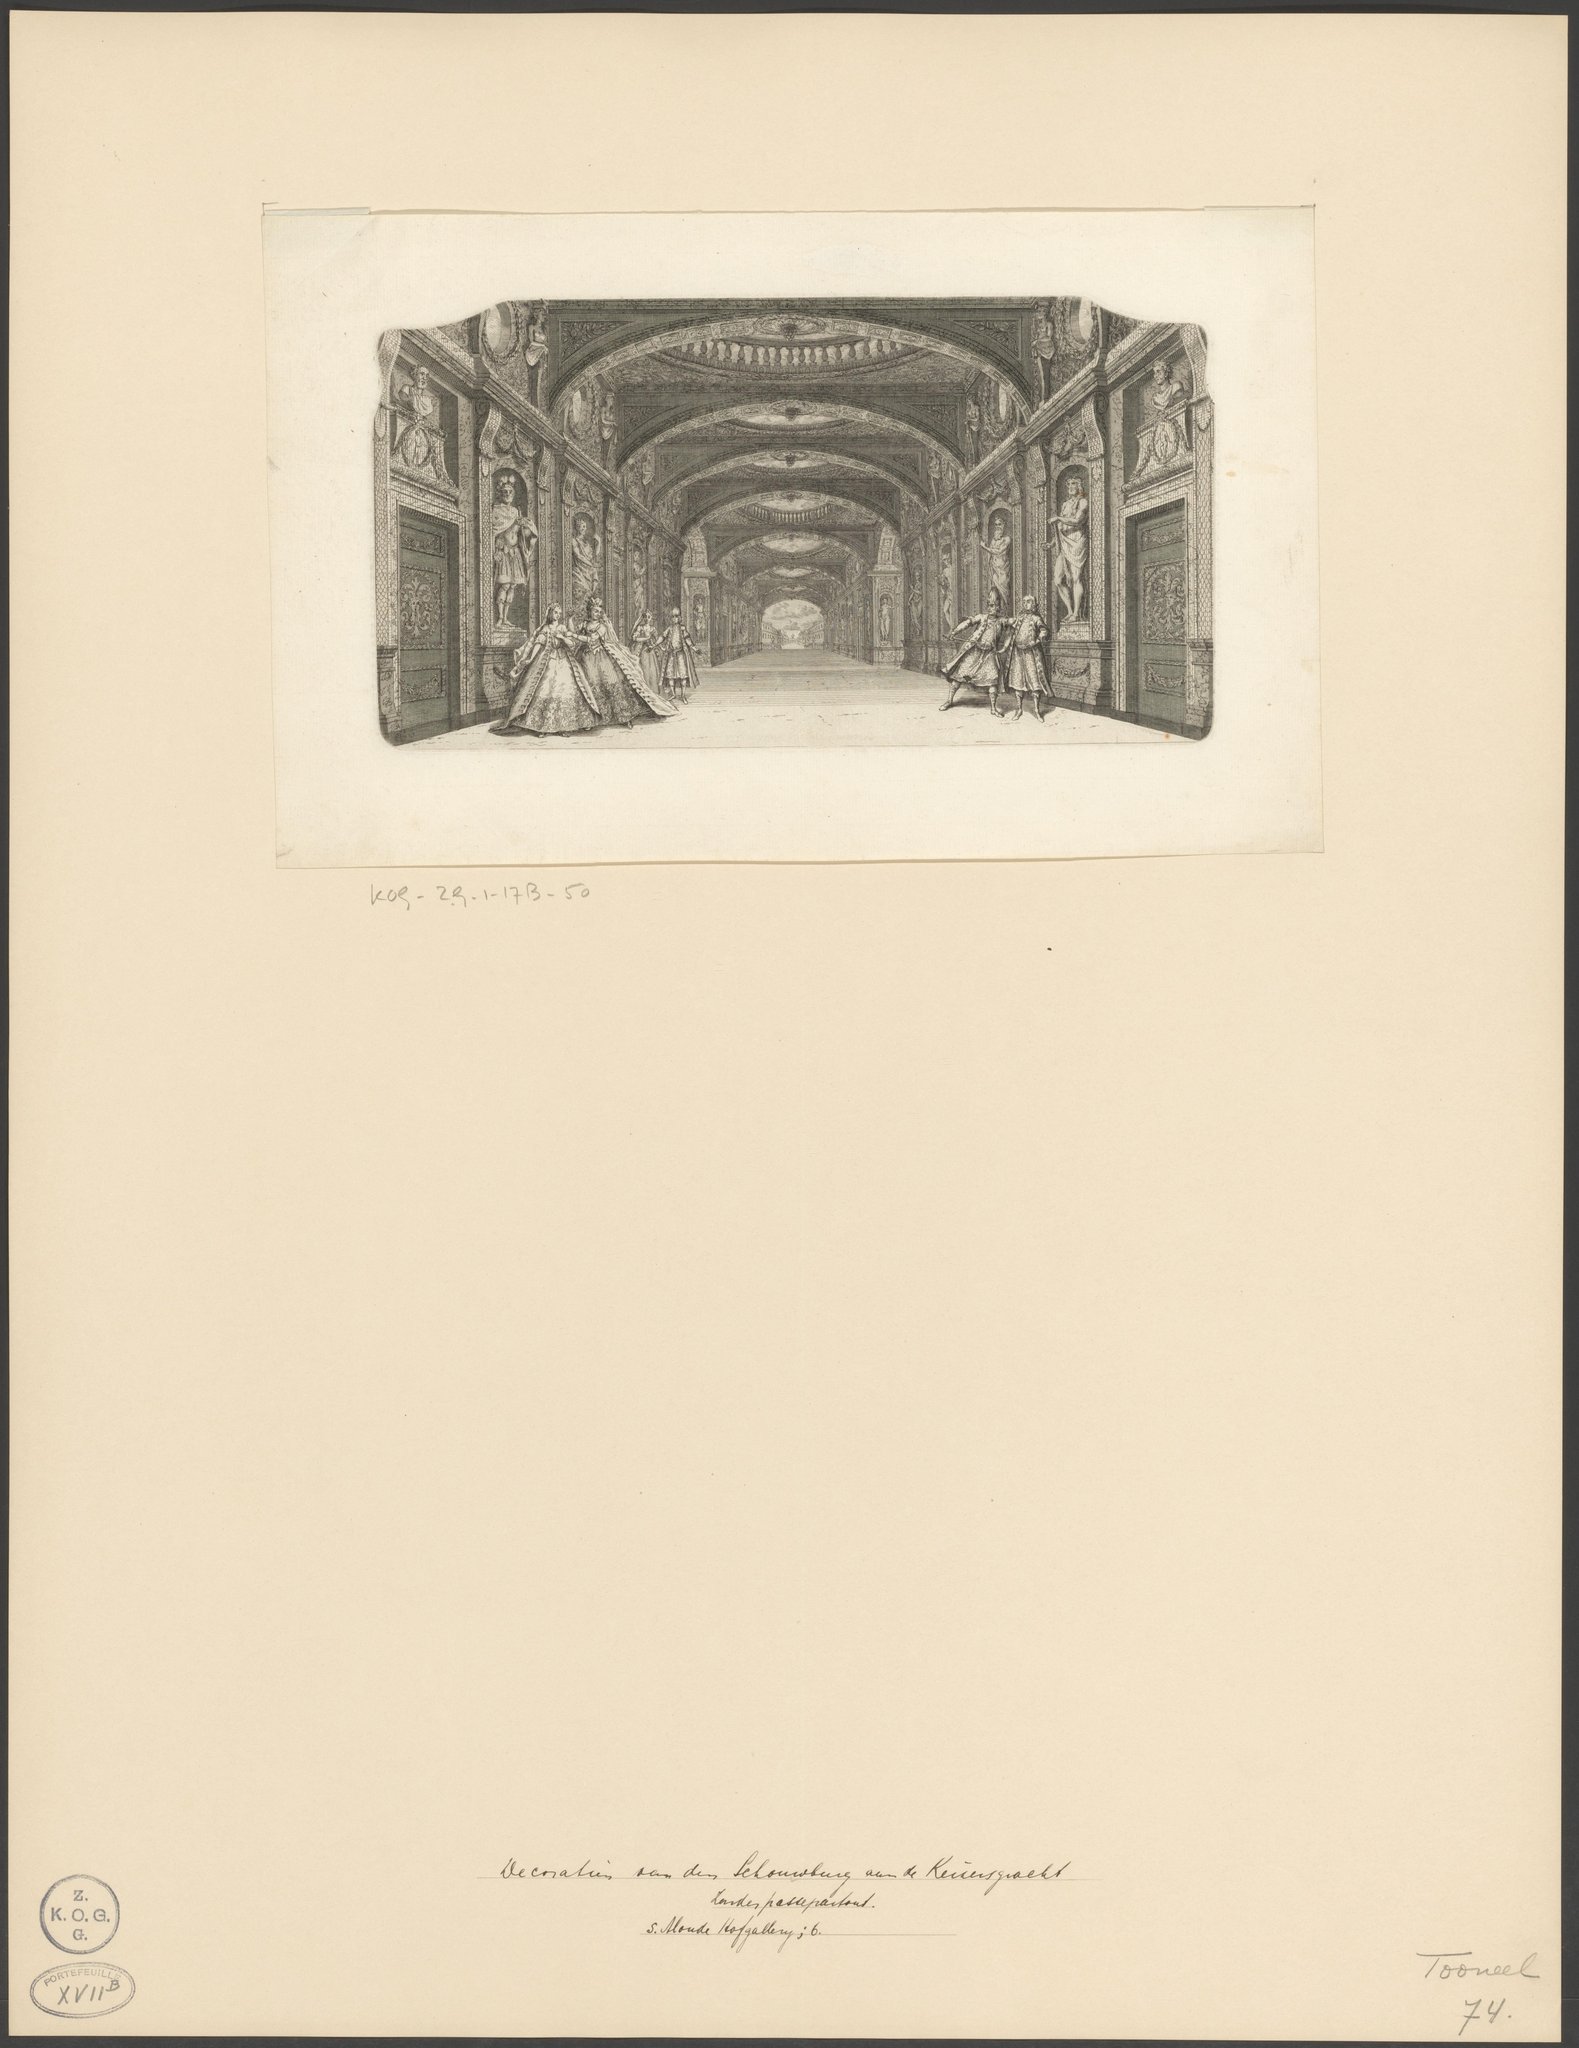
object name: print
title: Toneeldecors van de Amsterdamse Schouwburg, ca. 1760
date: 1736-1738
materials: paper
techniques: engraving, etching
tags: theatre, theatrical performance, stage design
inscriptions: collector's mark: Lugt 1641, stamp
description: Scène uit het toneelstuk "Het huwelyk van Orondates en Statira. Treurspel." door Jean Magnon (vertaald door D. Lingelbach), Amsterdam 1715. Deze platen zijn in verschillende groepen in verschillende periodes vervaardigd tussen 1738-1760 en uitgegeven in verschillende series ca. 1760 en ca. 1770-1772. De platen zijn door Muller ingedeeld bij de platen van de brand van de Amsterdamse Schouwburg in 1772.